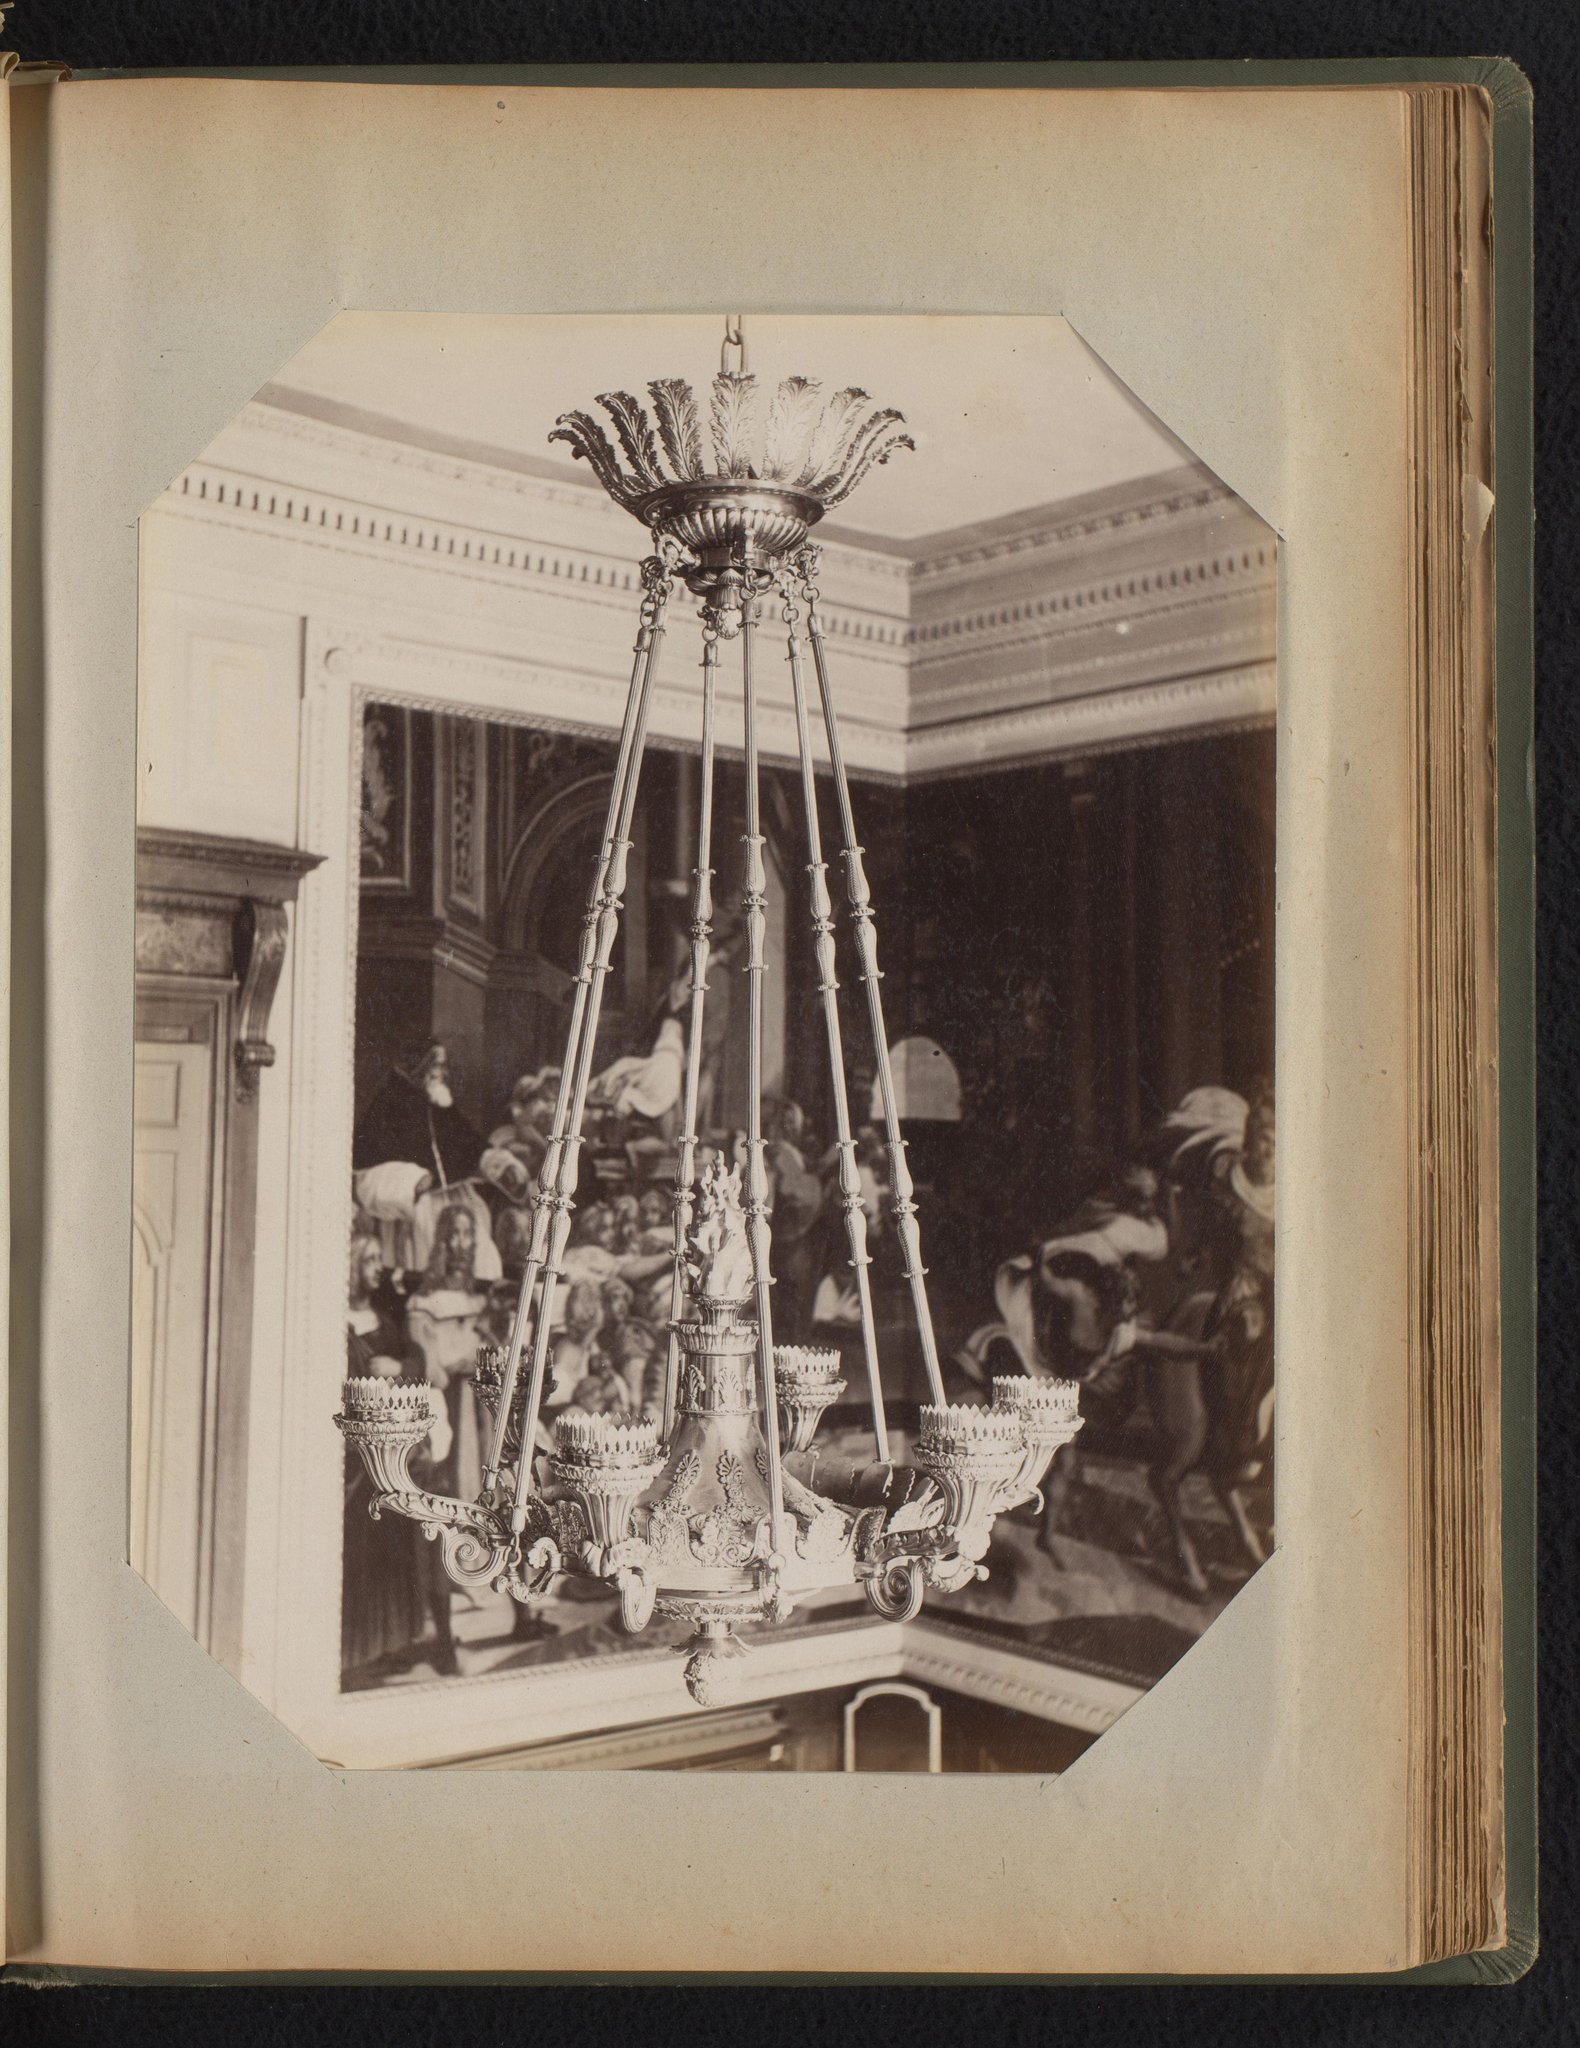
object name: photograph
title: Bronzen kroonluchter met fijn gedecoreerde kandelaars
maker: Anonymous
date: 1860-1900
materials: paper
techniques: albumen print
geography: france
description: Onderdeel van een serie met betrekking tot het interieur van het paleis van Versailles met kroonluchters, deuren, portalen en meubelstukken.